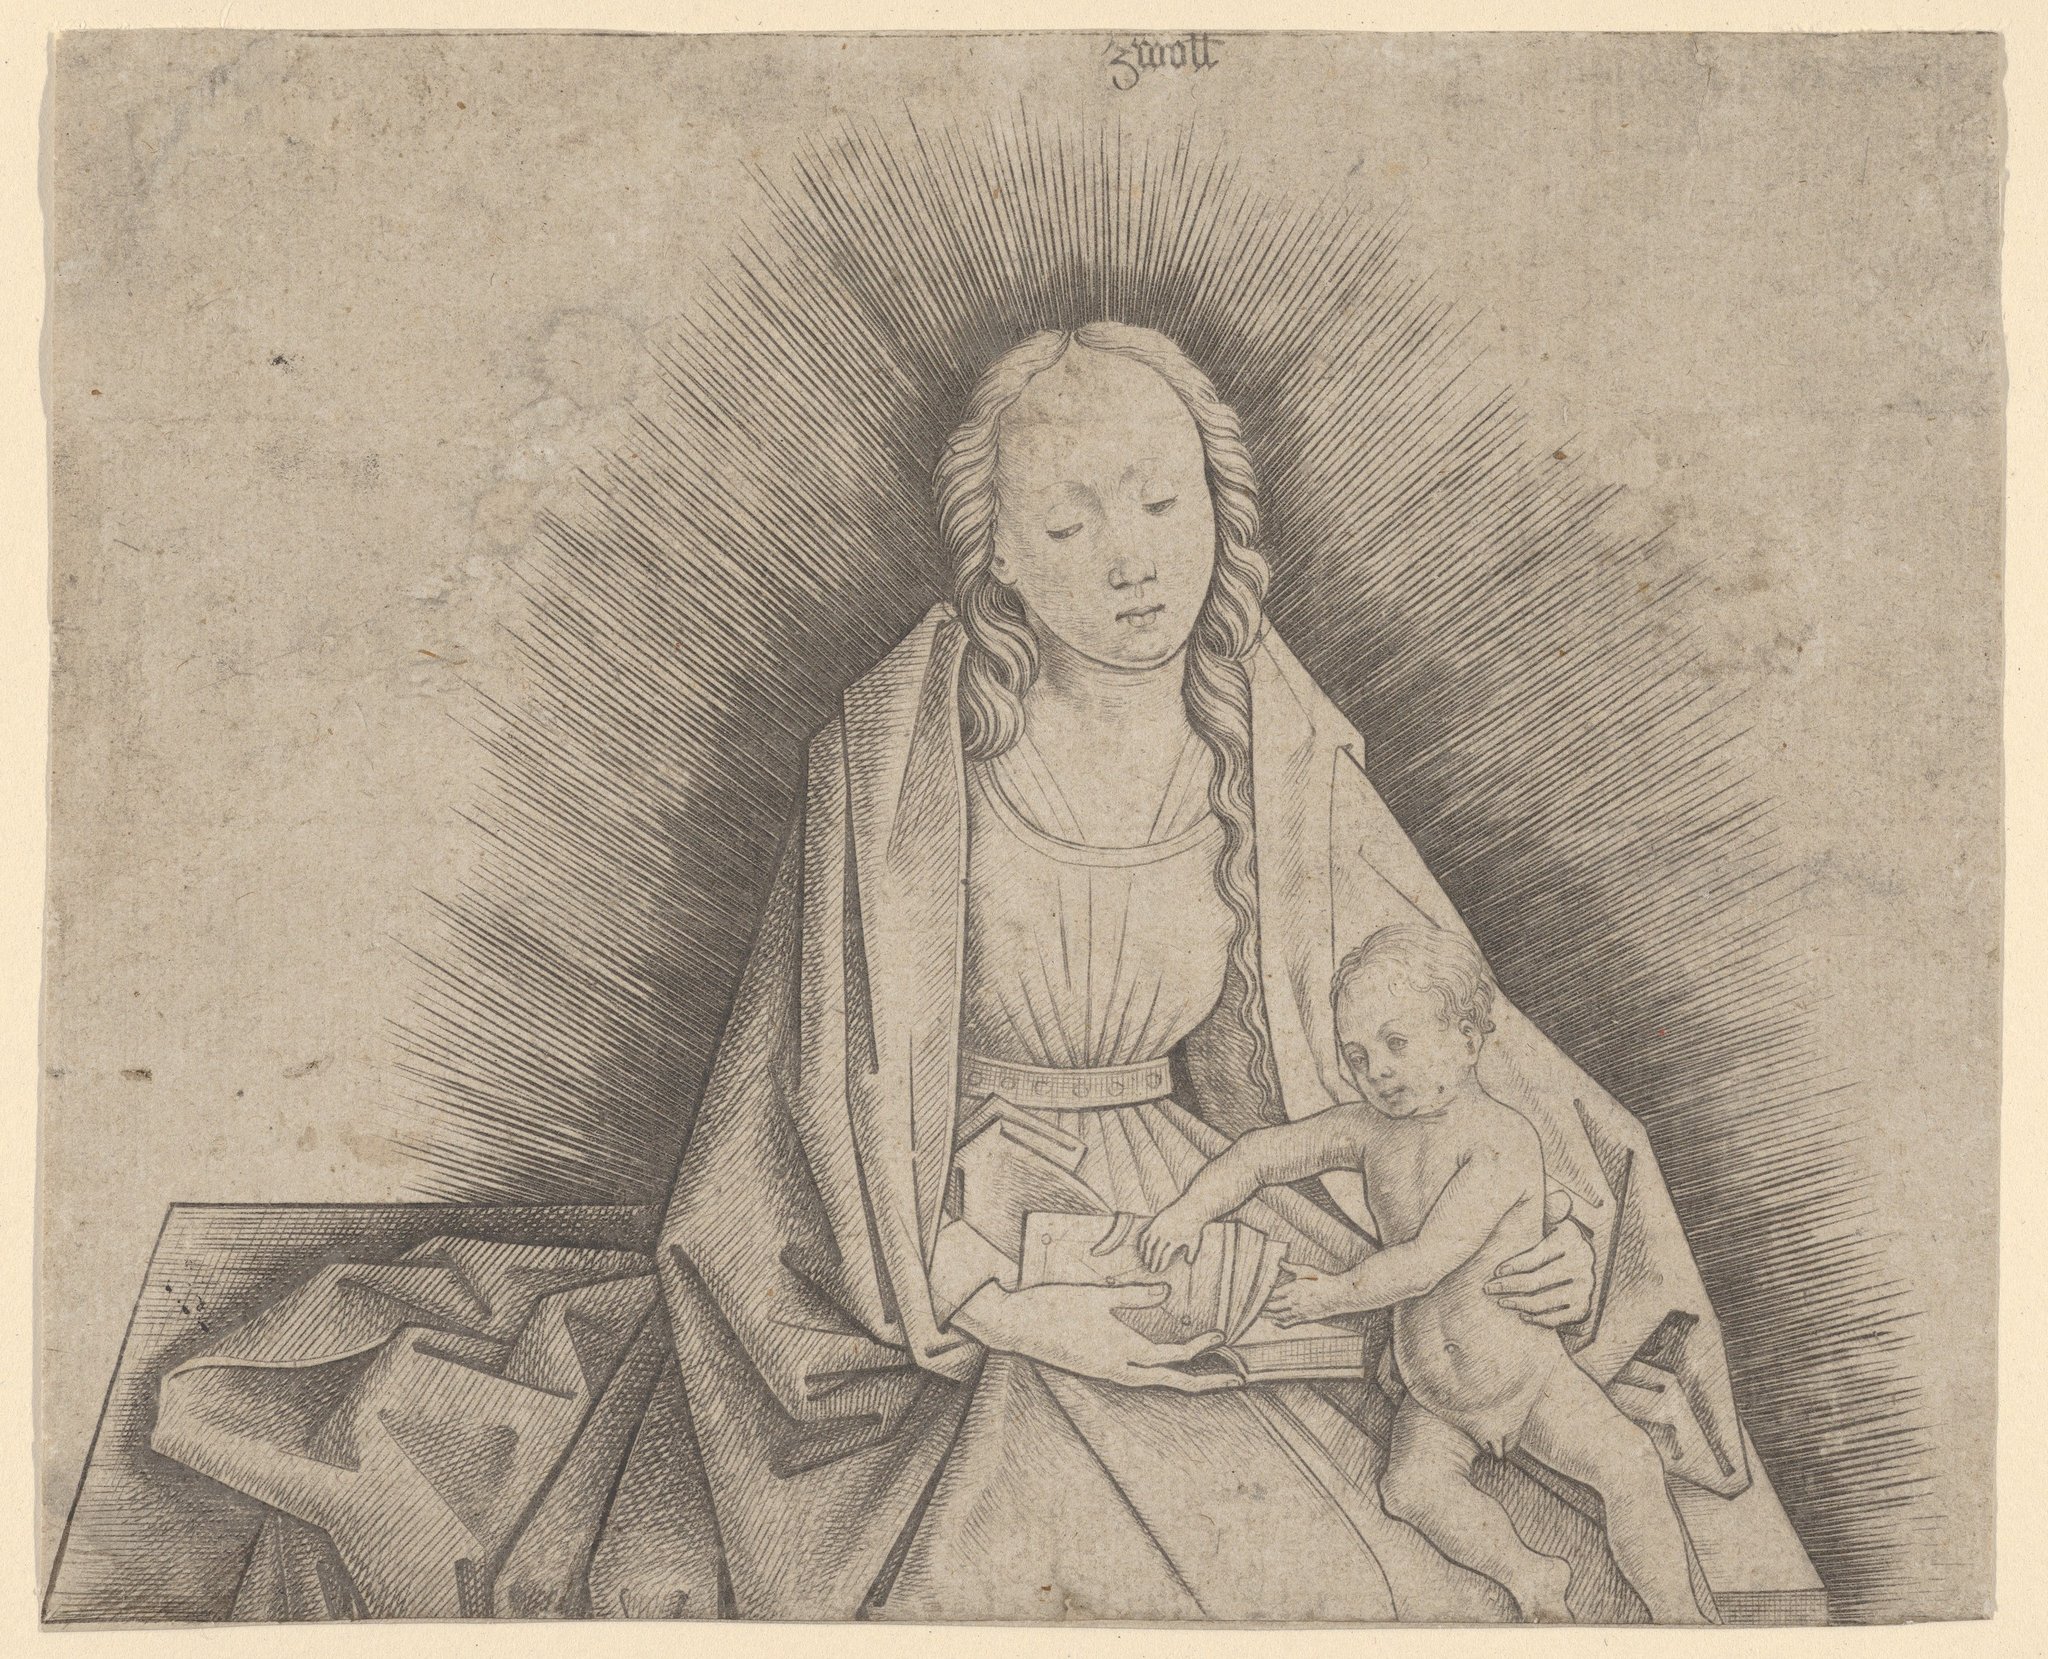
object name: print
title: Virgin and Child (upper portion)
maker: master iam of zwolle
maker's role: artist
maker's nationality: netherlandish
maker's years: 1465-1495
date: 1467-1500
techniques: engraving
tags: madonna and child